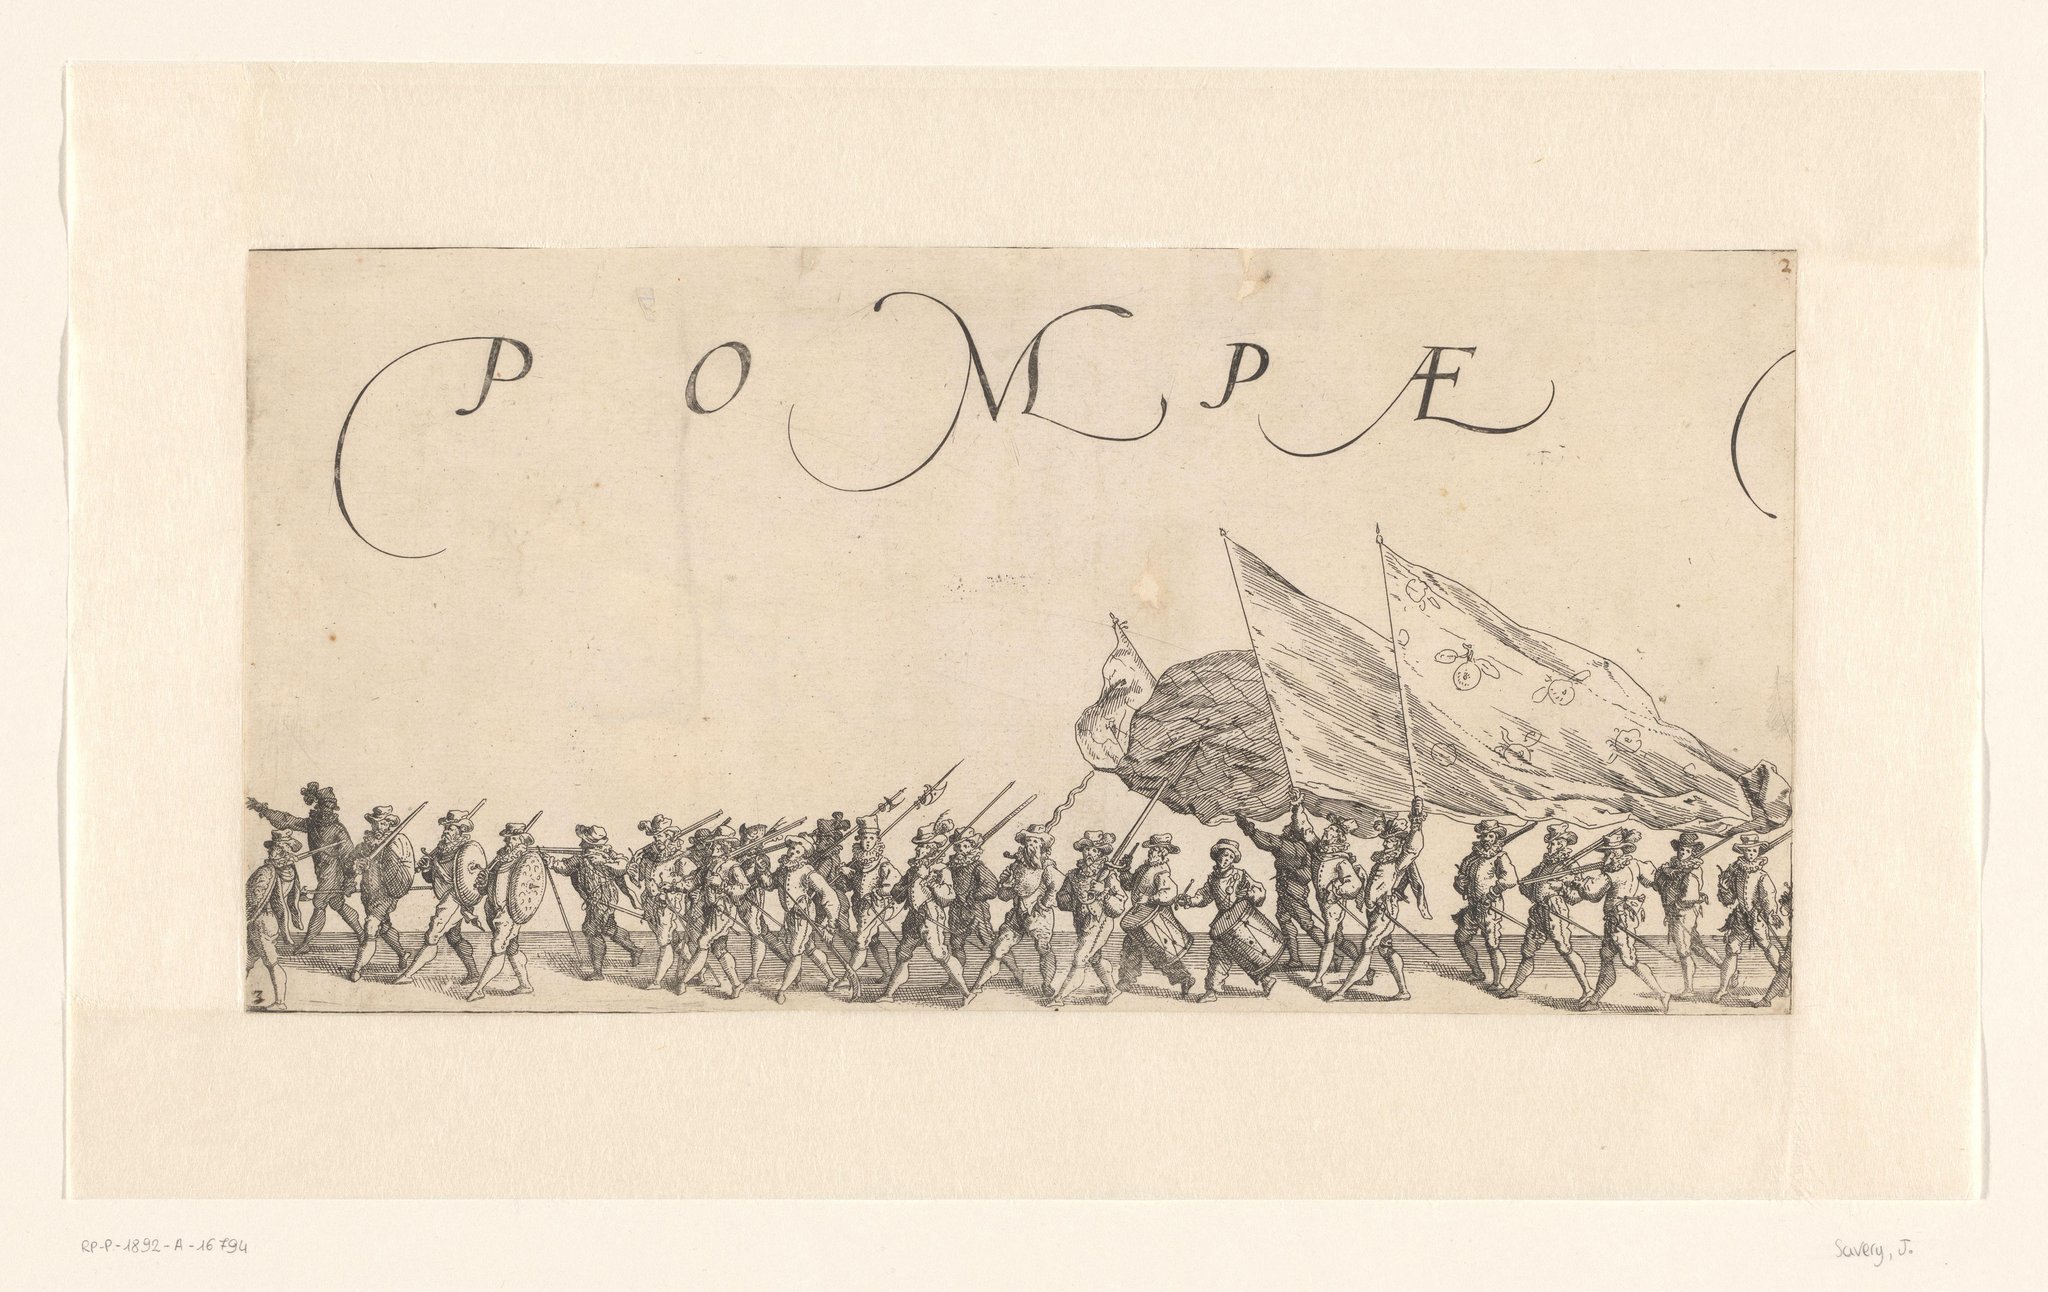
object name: print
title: [...] Pompae [...]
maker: jacob savery (i)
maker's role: draughtsman, painter, print maker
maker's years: 1566-1603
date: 1586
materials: paper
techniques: etching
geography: northern netherlands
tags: robert dudley (1st earl of leicester), triumphal entry and public reception, pageant, 'entrée solennelle', 'joyeuse entrée', historical persons, the hague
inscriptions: collector's mark: Lugt 2228, number: ‘2’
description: Dit blad is het tweede blad uit een reeks van twaalf bladen die samen de intocht van Robert Dudley te Den Haag vormen, zie RP-P-OB-80.445.